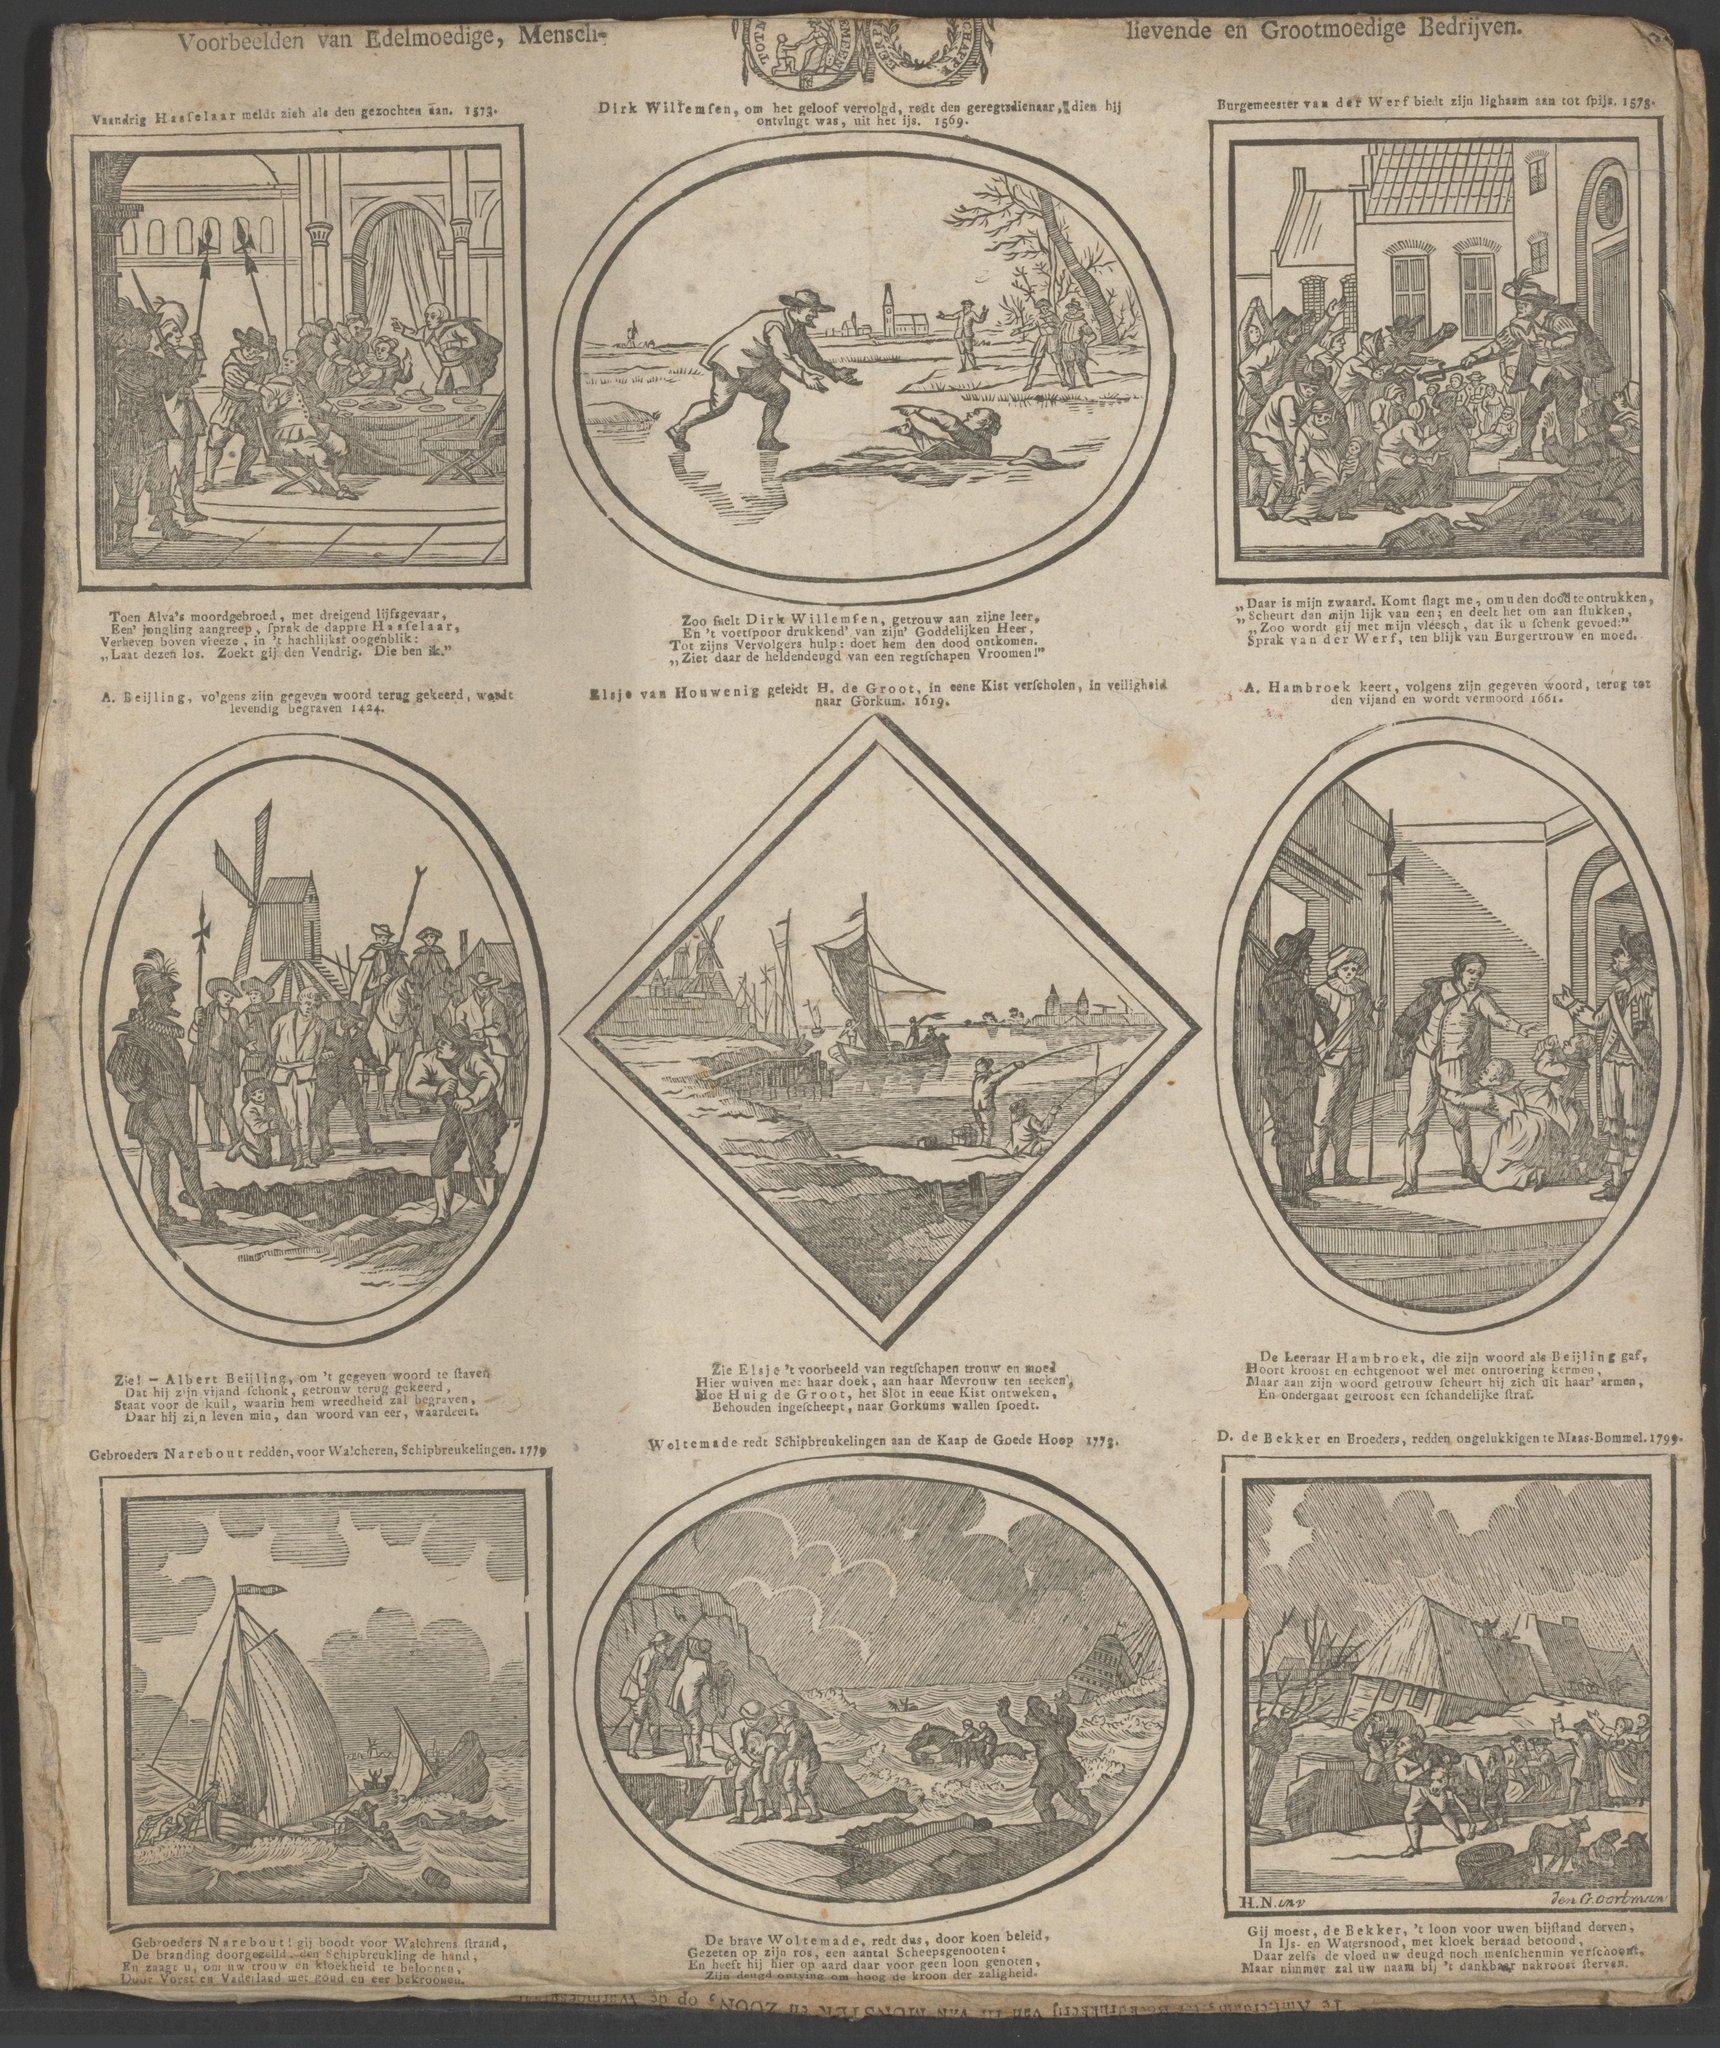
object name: print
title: Voorbeelden van edelmoedige, mensch- / lievende en grootmoedige bedrijven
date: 1805-1820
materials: paper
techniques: letterpress printing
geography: amsterdam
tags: unselfishness (+ situation or event (especially in genre-painting) with symbolical connotation)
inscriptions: stamp, collector's mark: Lugt 1641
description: Blad met negen voorstellingen van daden van personen uit de Nederlandse geschiedenis die getuigen van edelmoedigheid. Voorstellingen geheel of grotendeels overgenomen van oude prenten. Bovenaan het zegel van de Maatschappij tot Nut van 't Algemeen. Boven elke afbeelding een titel, onder elke afbeelding een vierregelig vers. Genummerd rechtsboven: Z. Onderwerpsrubrieken binnen de Atlas Zeden en Gewoonten: Zeden en gewoonten in engeren zin, Des menschen begin, midden en einde, Kinderprenten opgeplakt op karton.